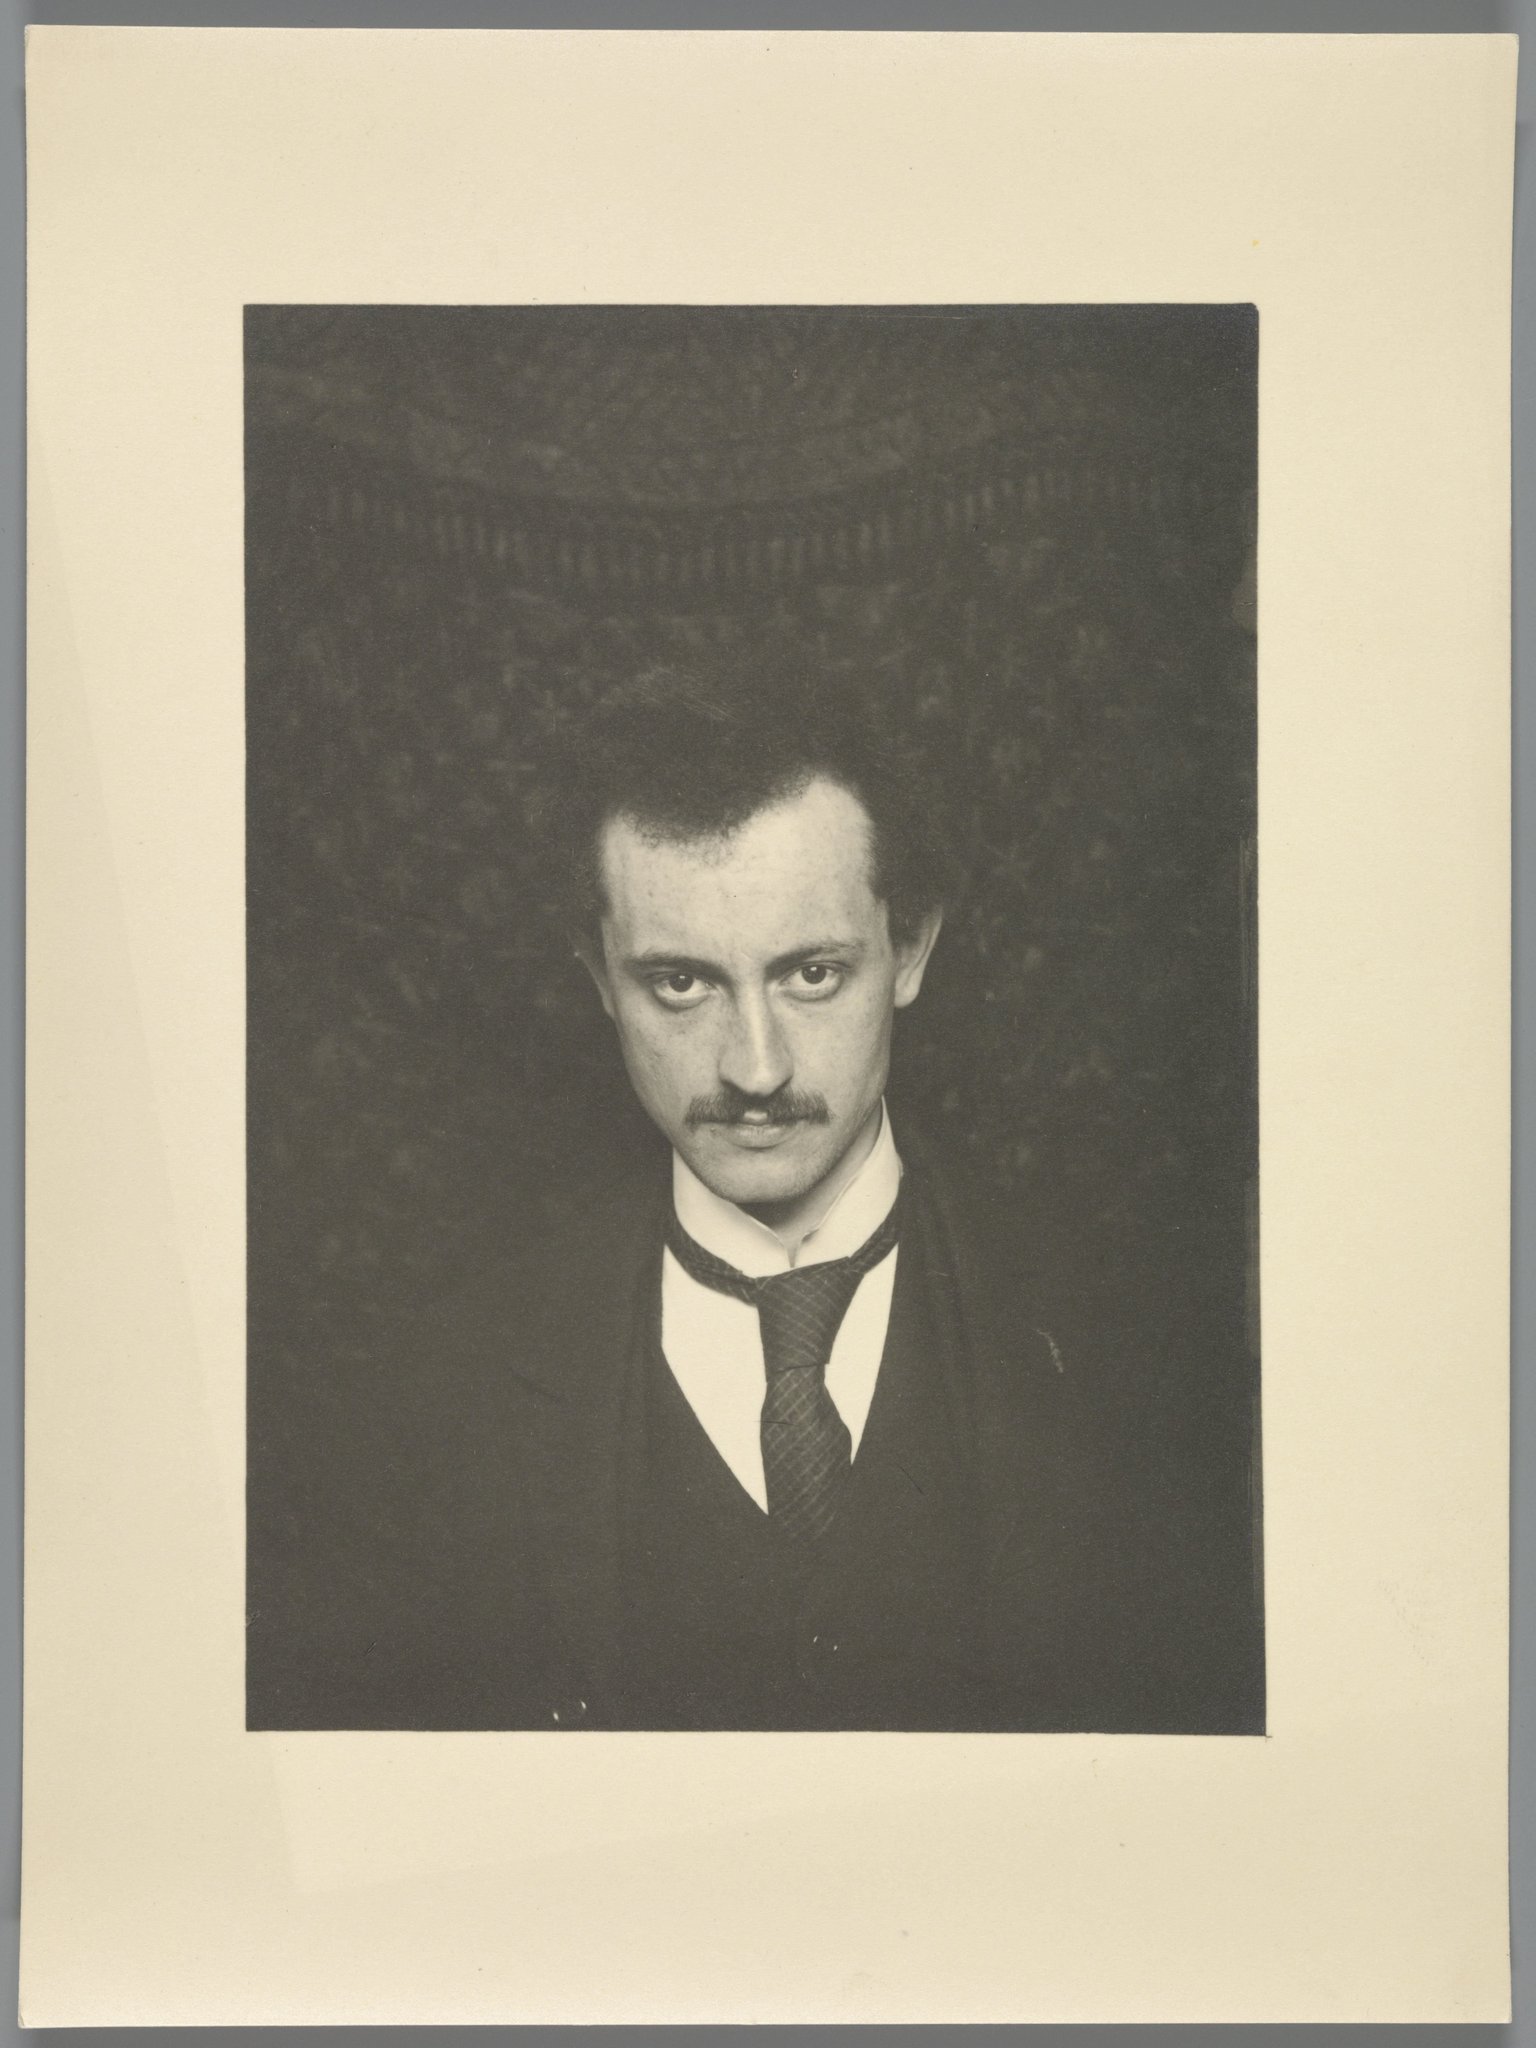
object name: photograph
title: Reproductie naar een foto van Willem Witsen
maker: Anonymous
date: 1860-1915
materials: paper, photographic support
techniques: gelatin silver print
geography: netherlands